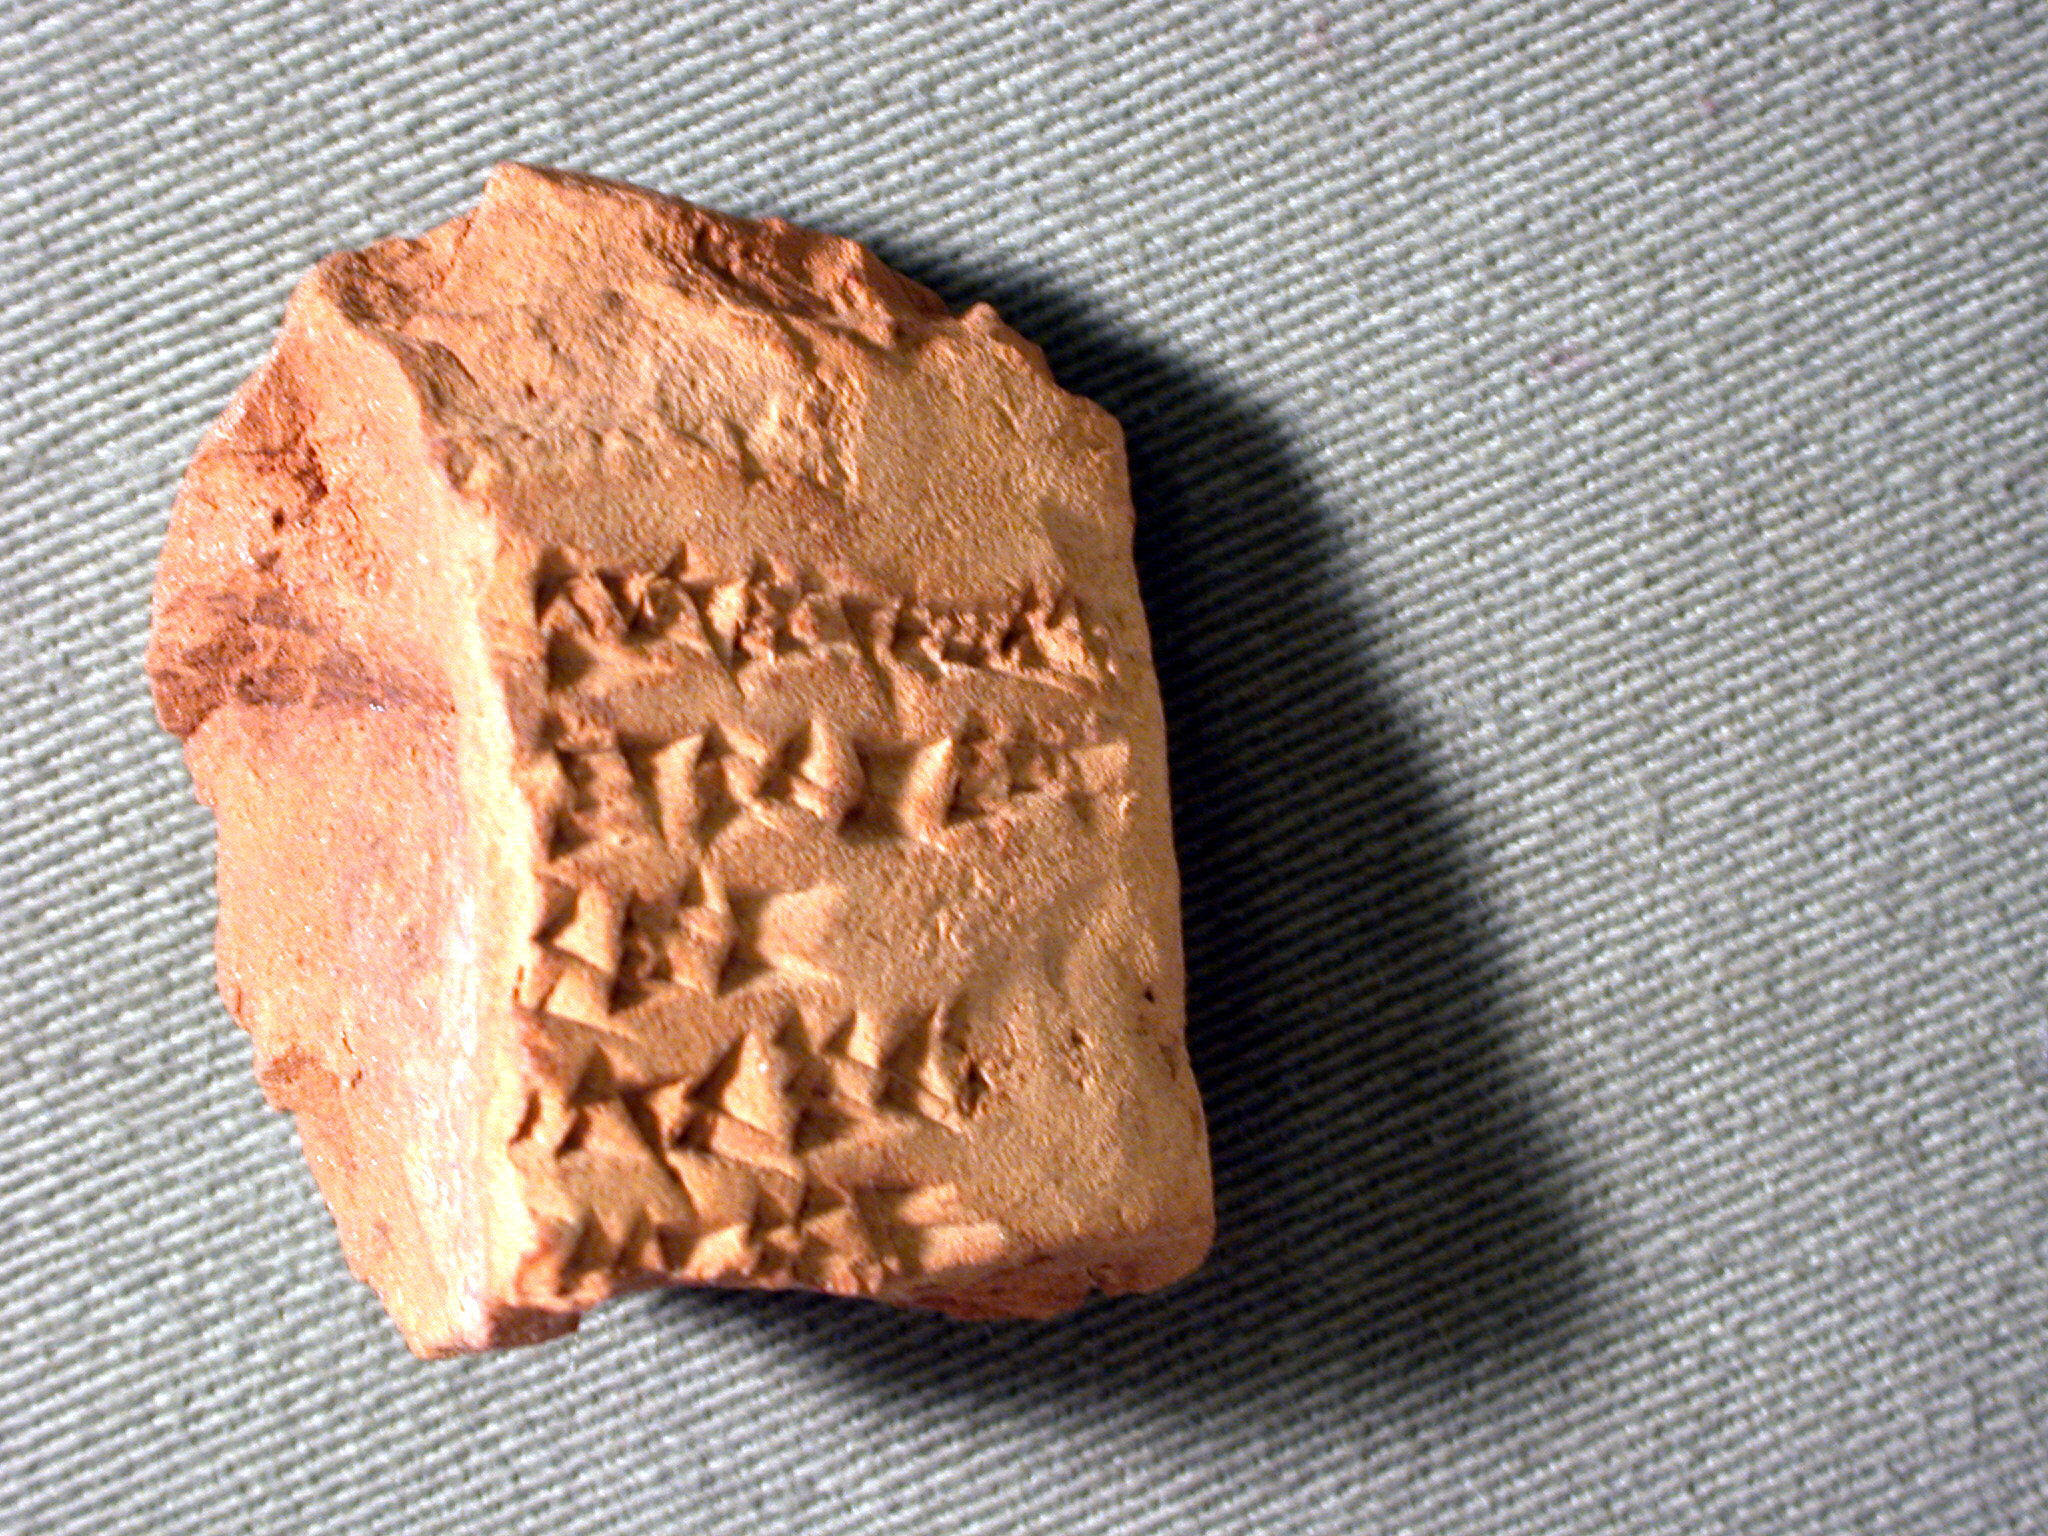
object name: cuneiform tablet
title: Cuneiform tablet: fragment of the witness list of a contract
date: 500-101 BCE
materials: clay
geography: mesopotamia